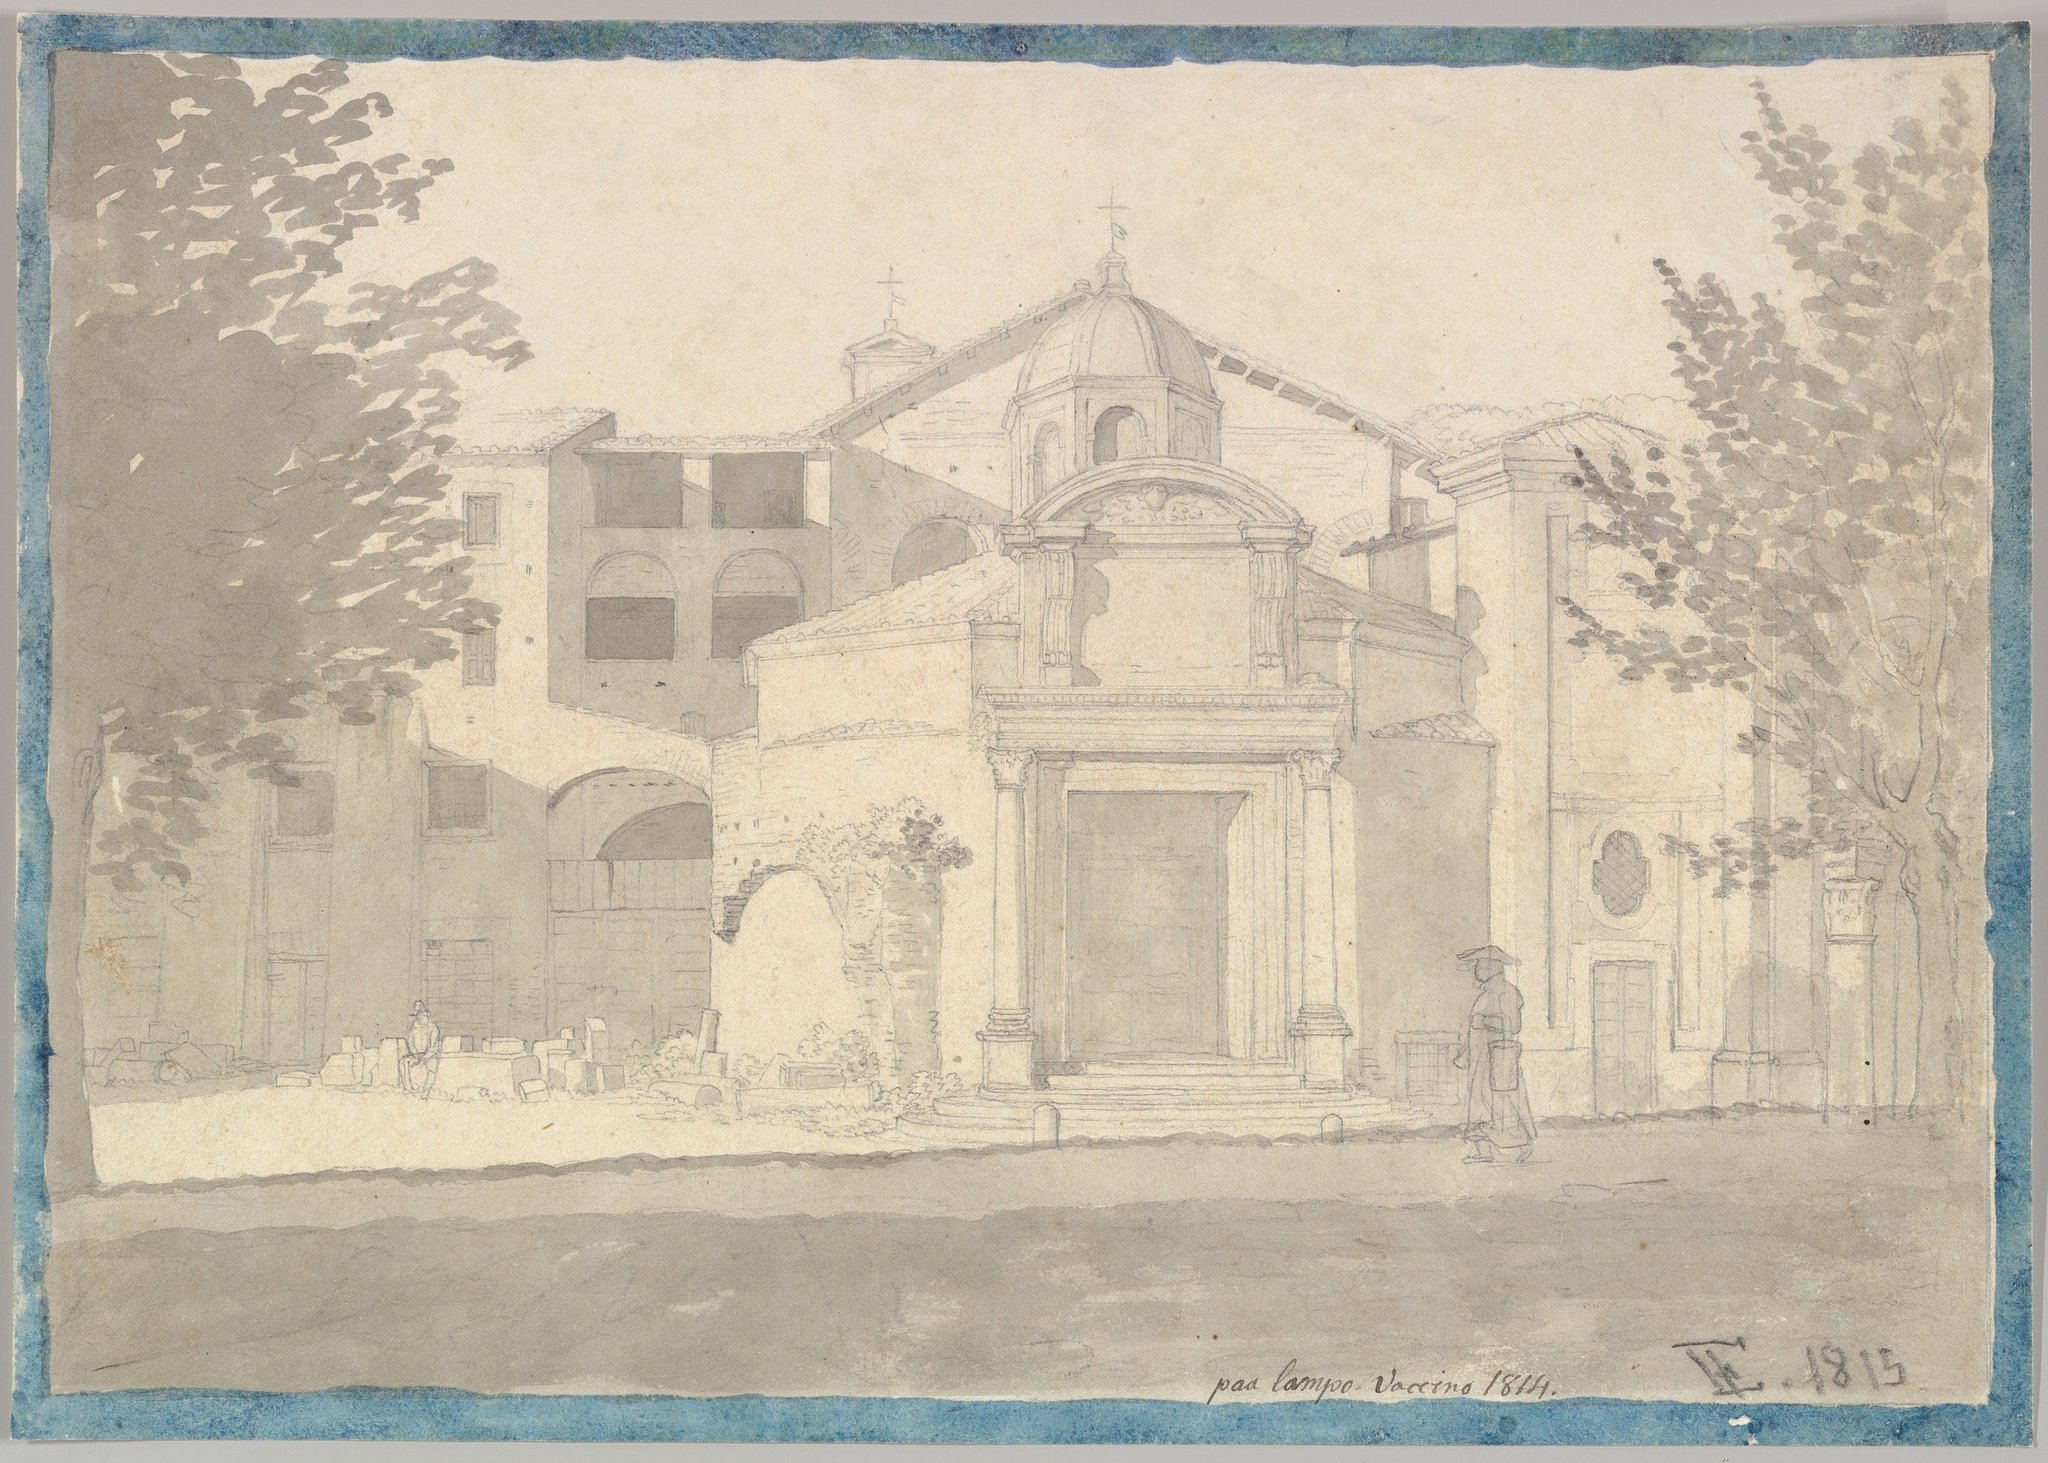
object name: drawing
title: A Section of the Via Sacra, Rome (The Church of Saints Cosmas and Damian)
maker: christoffer wilhelm eckersberg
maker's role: artist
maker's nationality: danish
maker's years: 1783-1853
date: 1814-1815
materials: graphite, watercolor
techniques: brush, wash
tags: churches